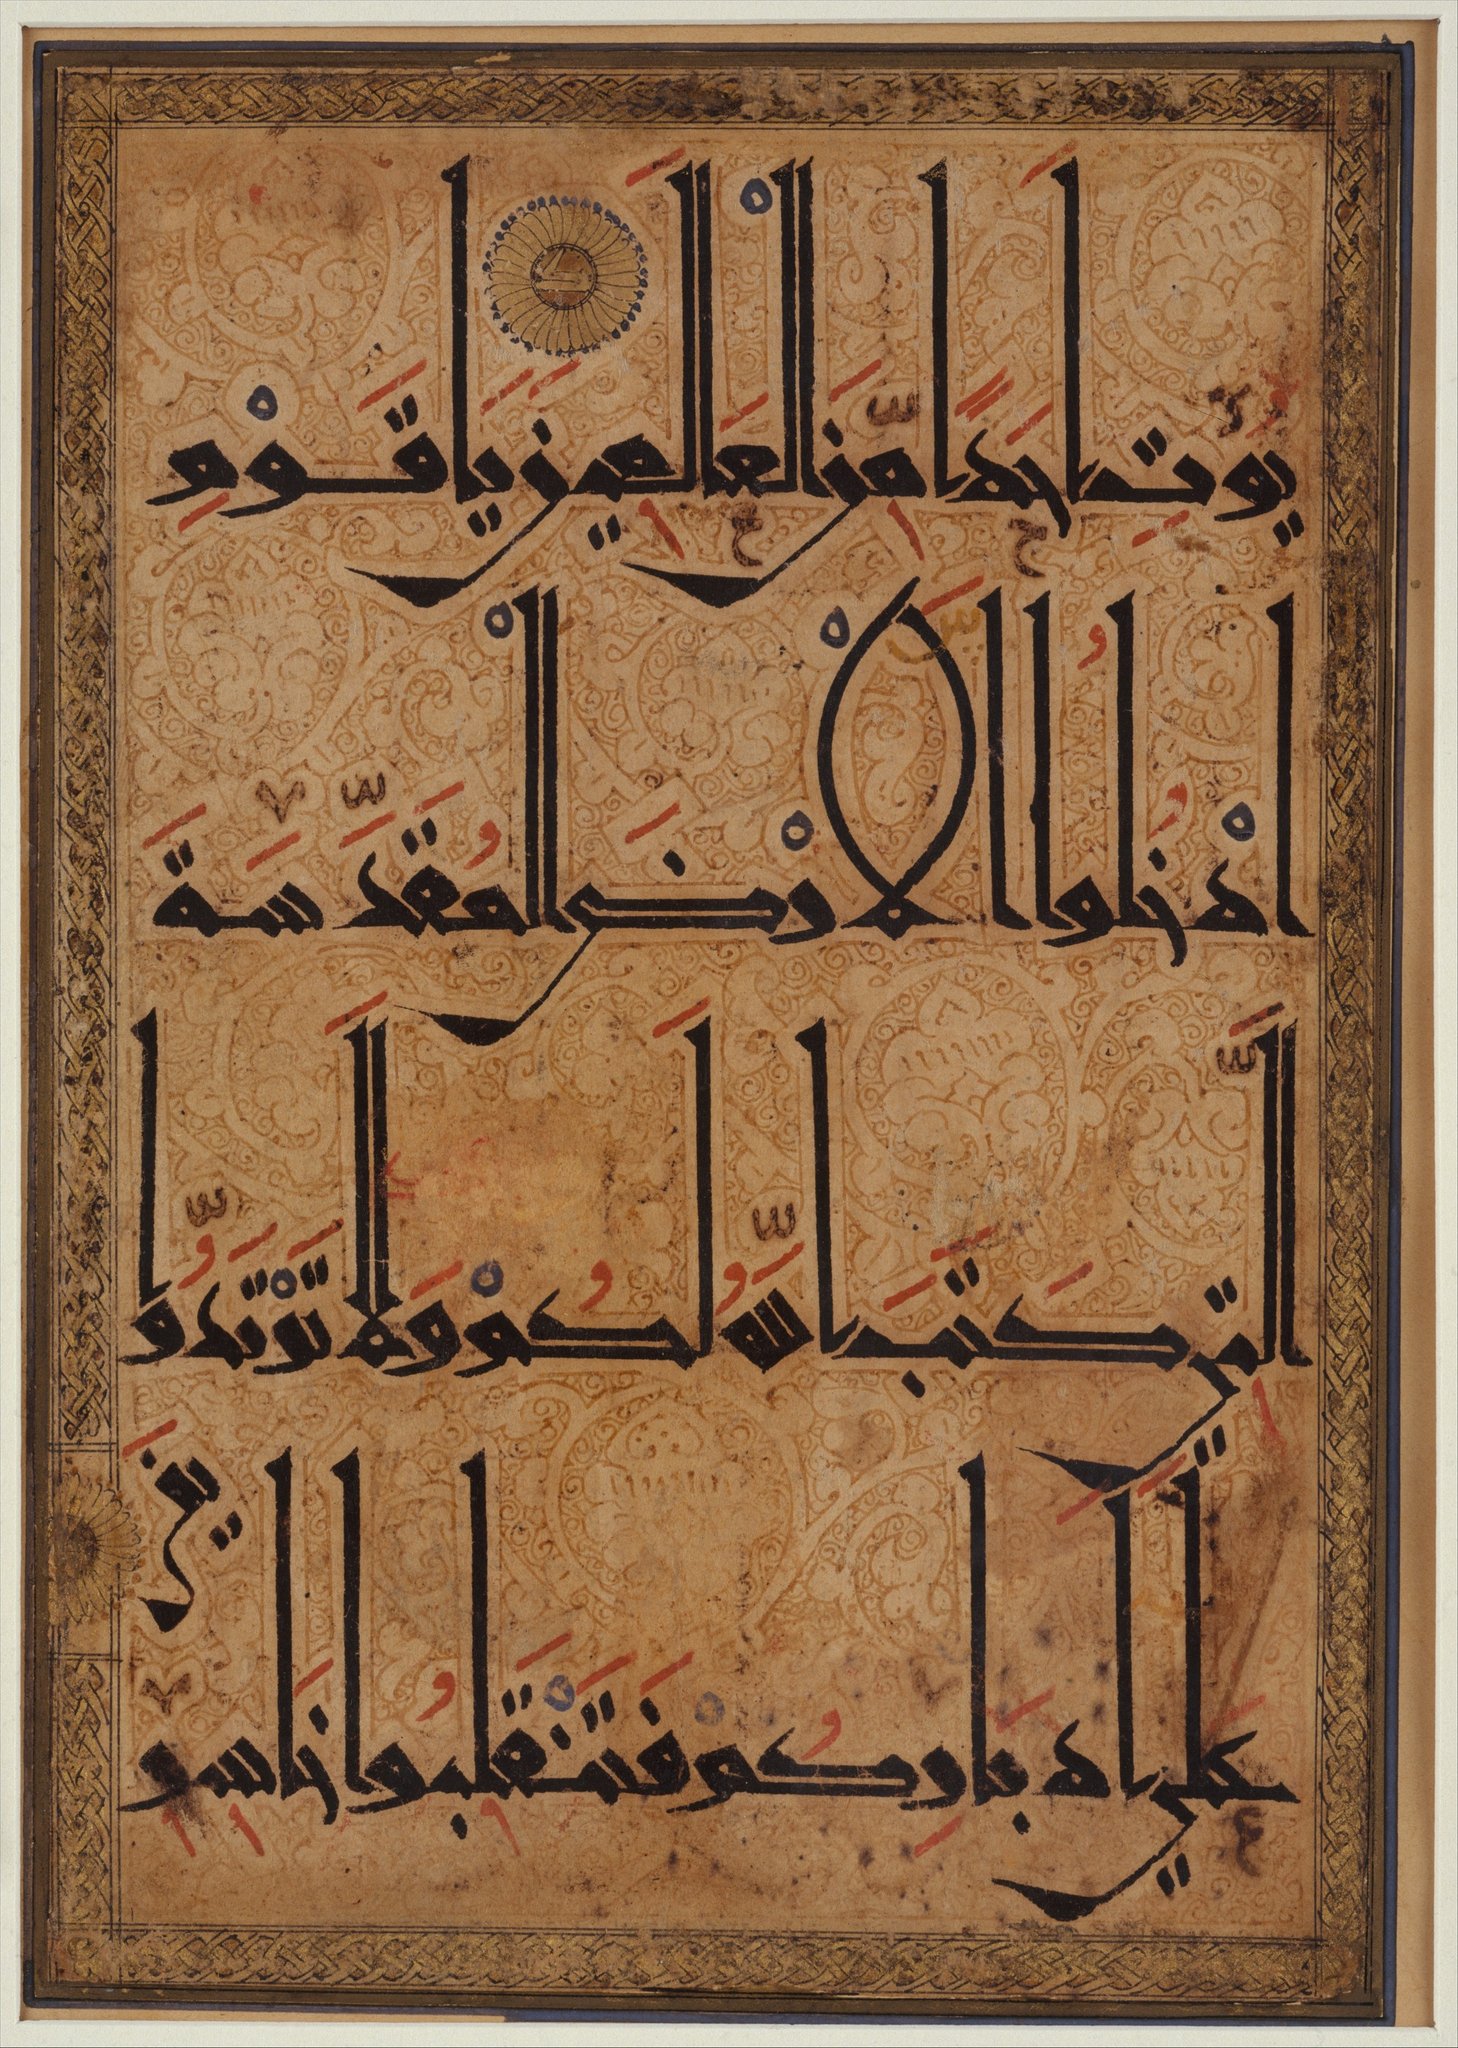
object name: folio from a non illustrated manuscript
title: Folio from a Qur'an Manuscript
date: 1180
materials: gold, ink, paper, watercolor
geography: iran or afghanistan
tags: qur'an